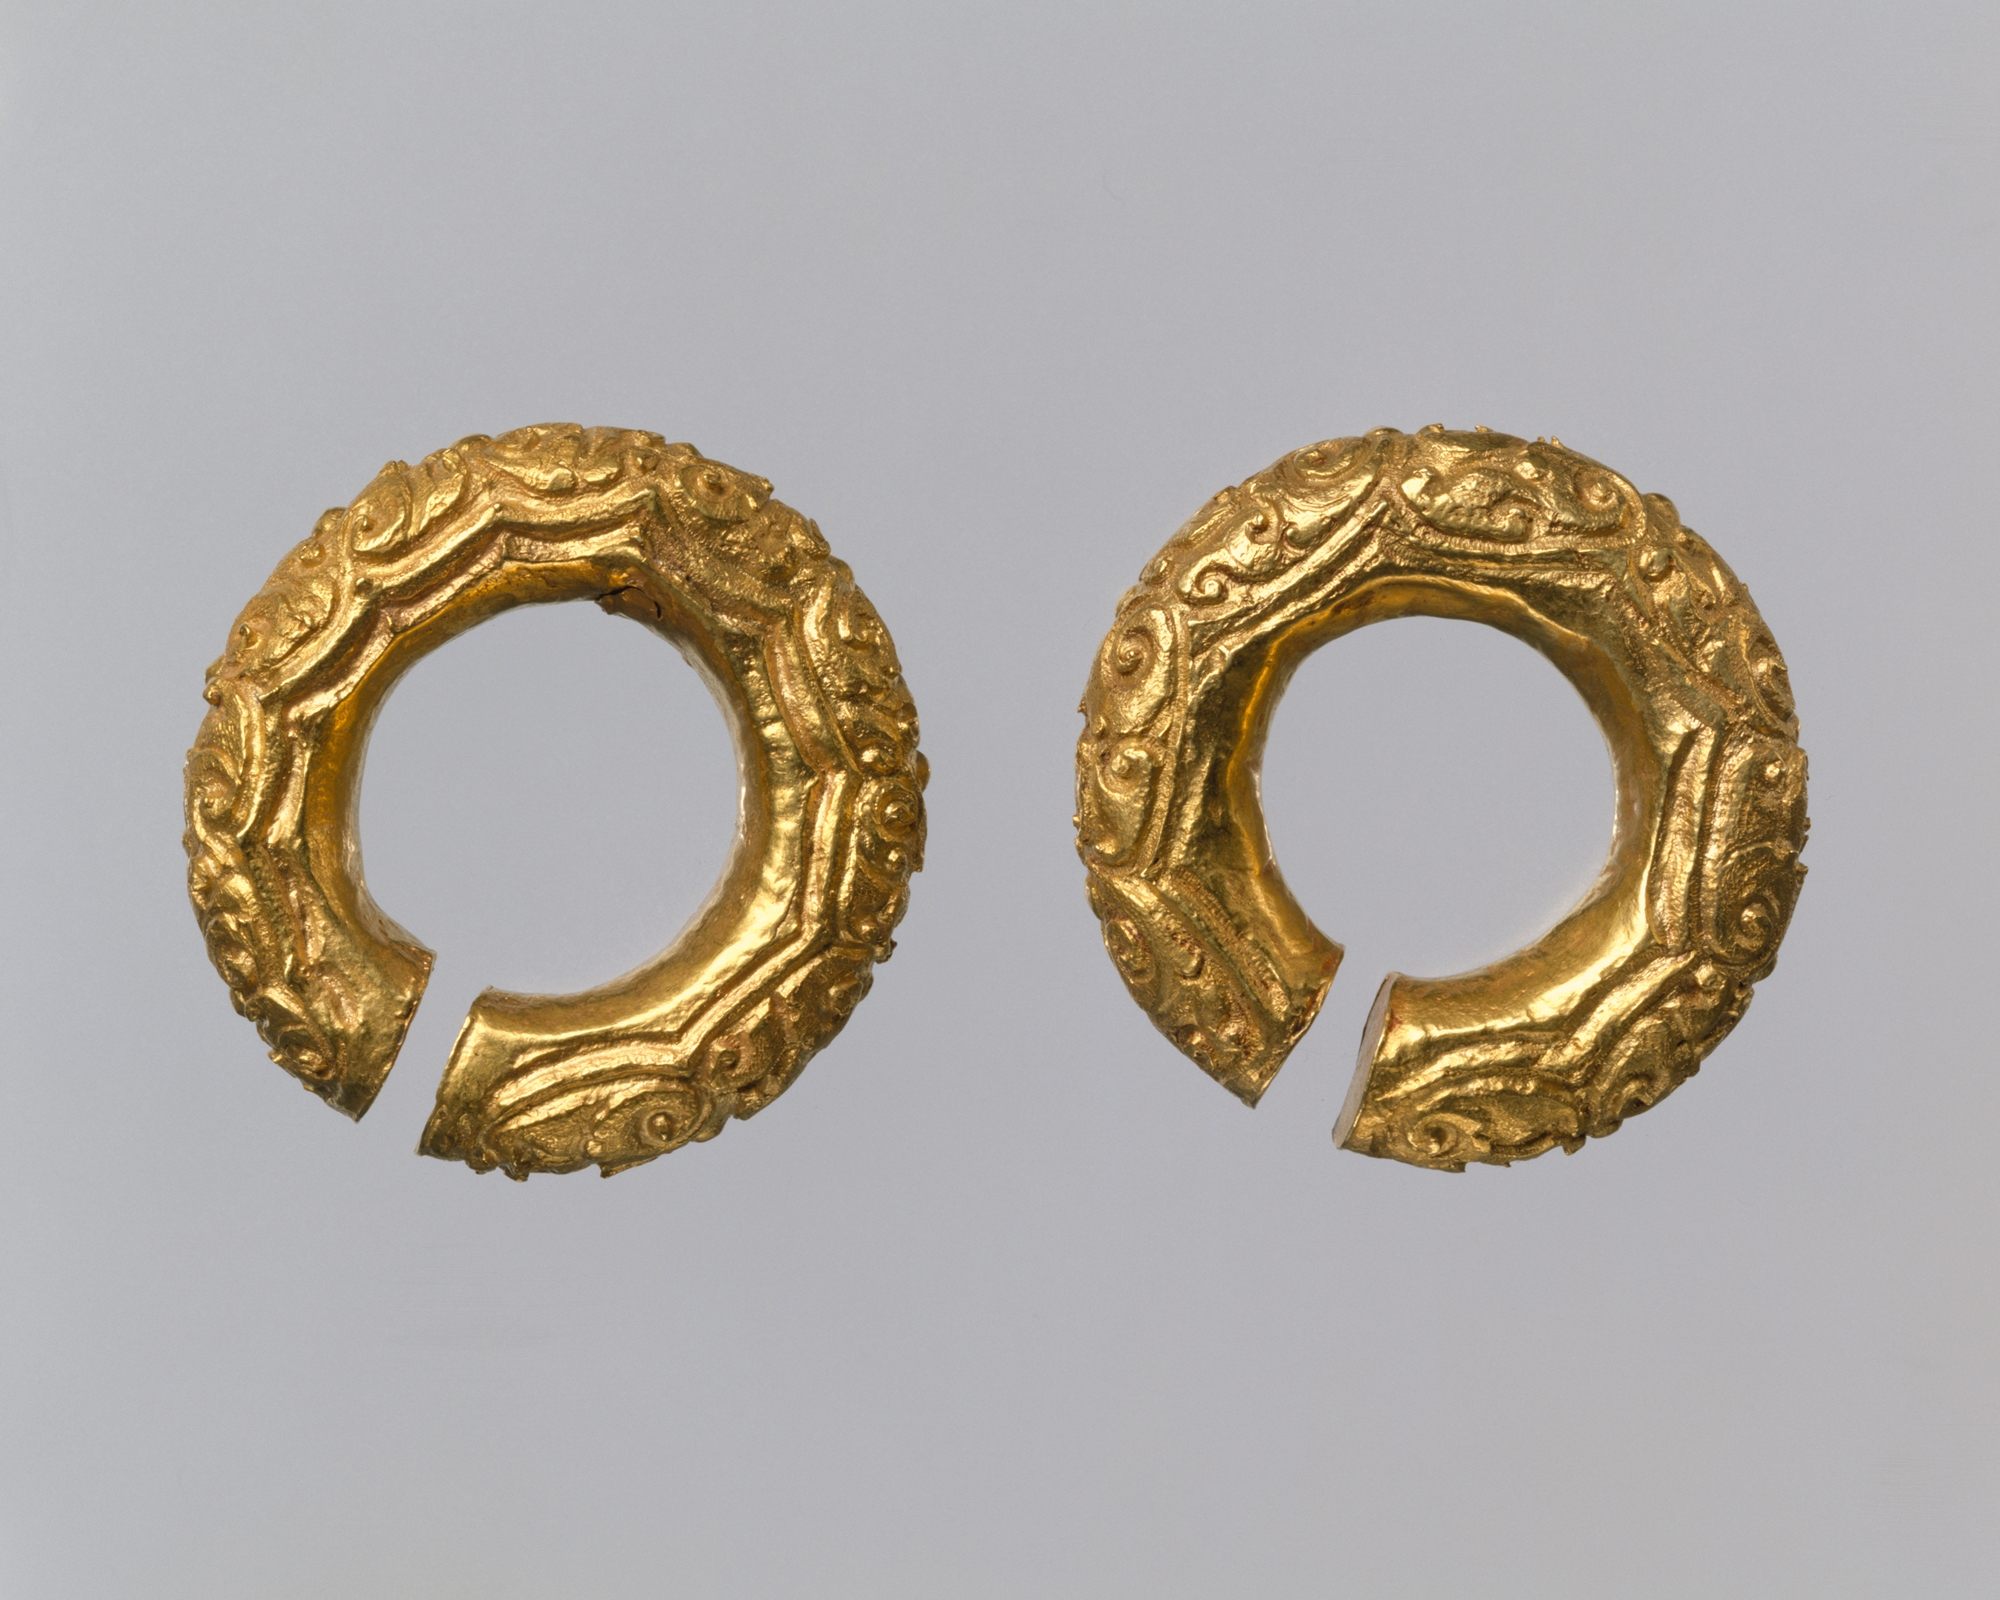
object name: pair of earring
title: Pair of Round Earrings, Foliate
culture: indonesian, central java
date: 701-1200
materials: gold